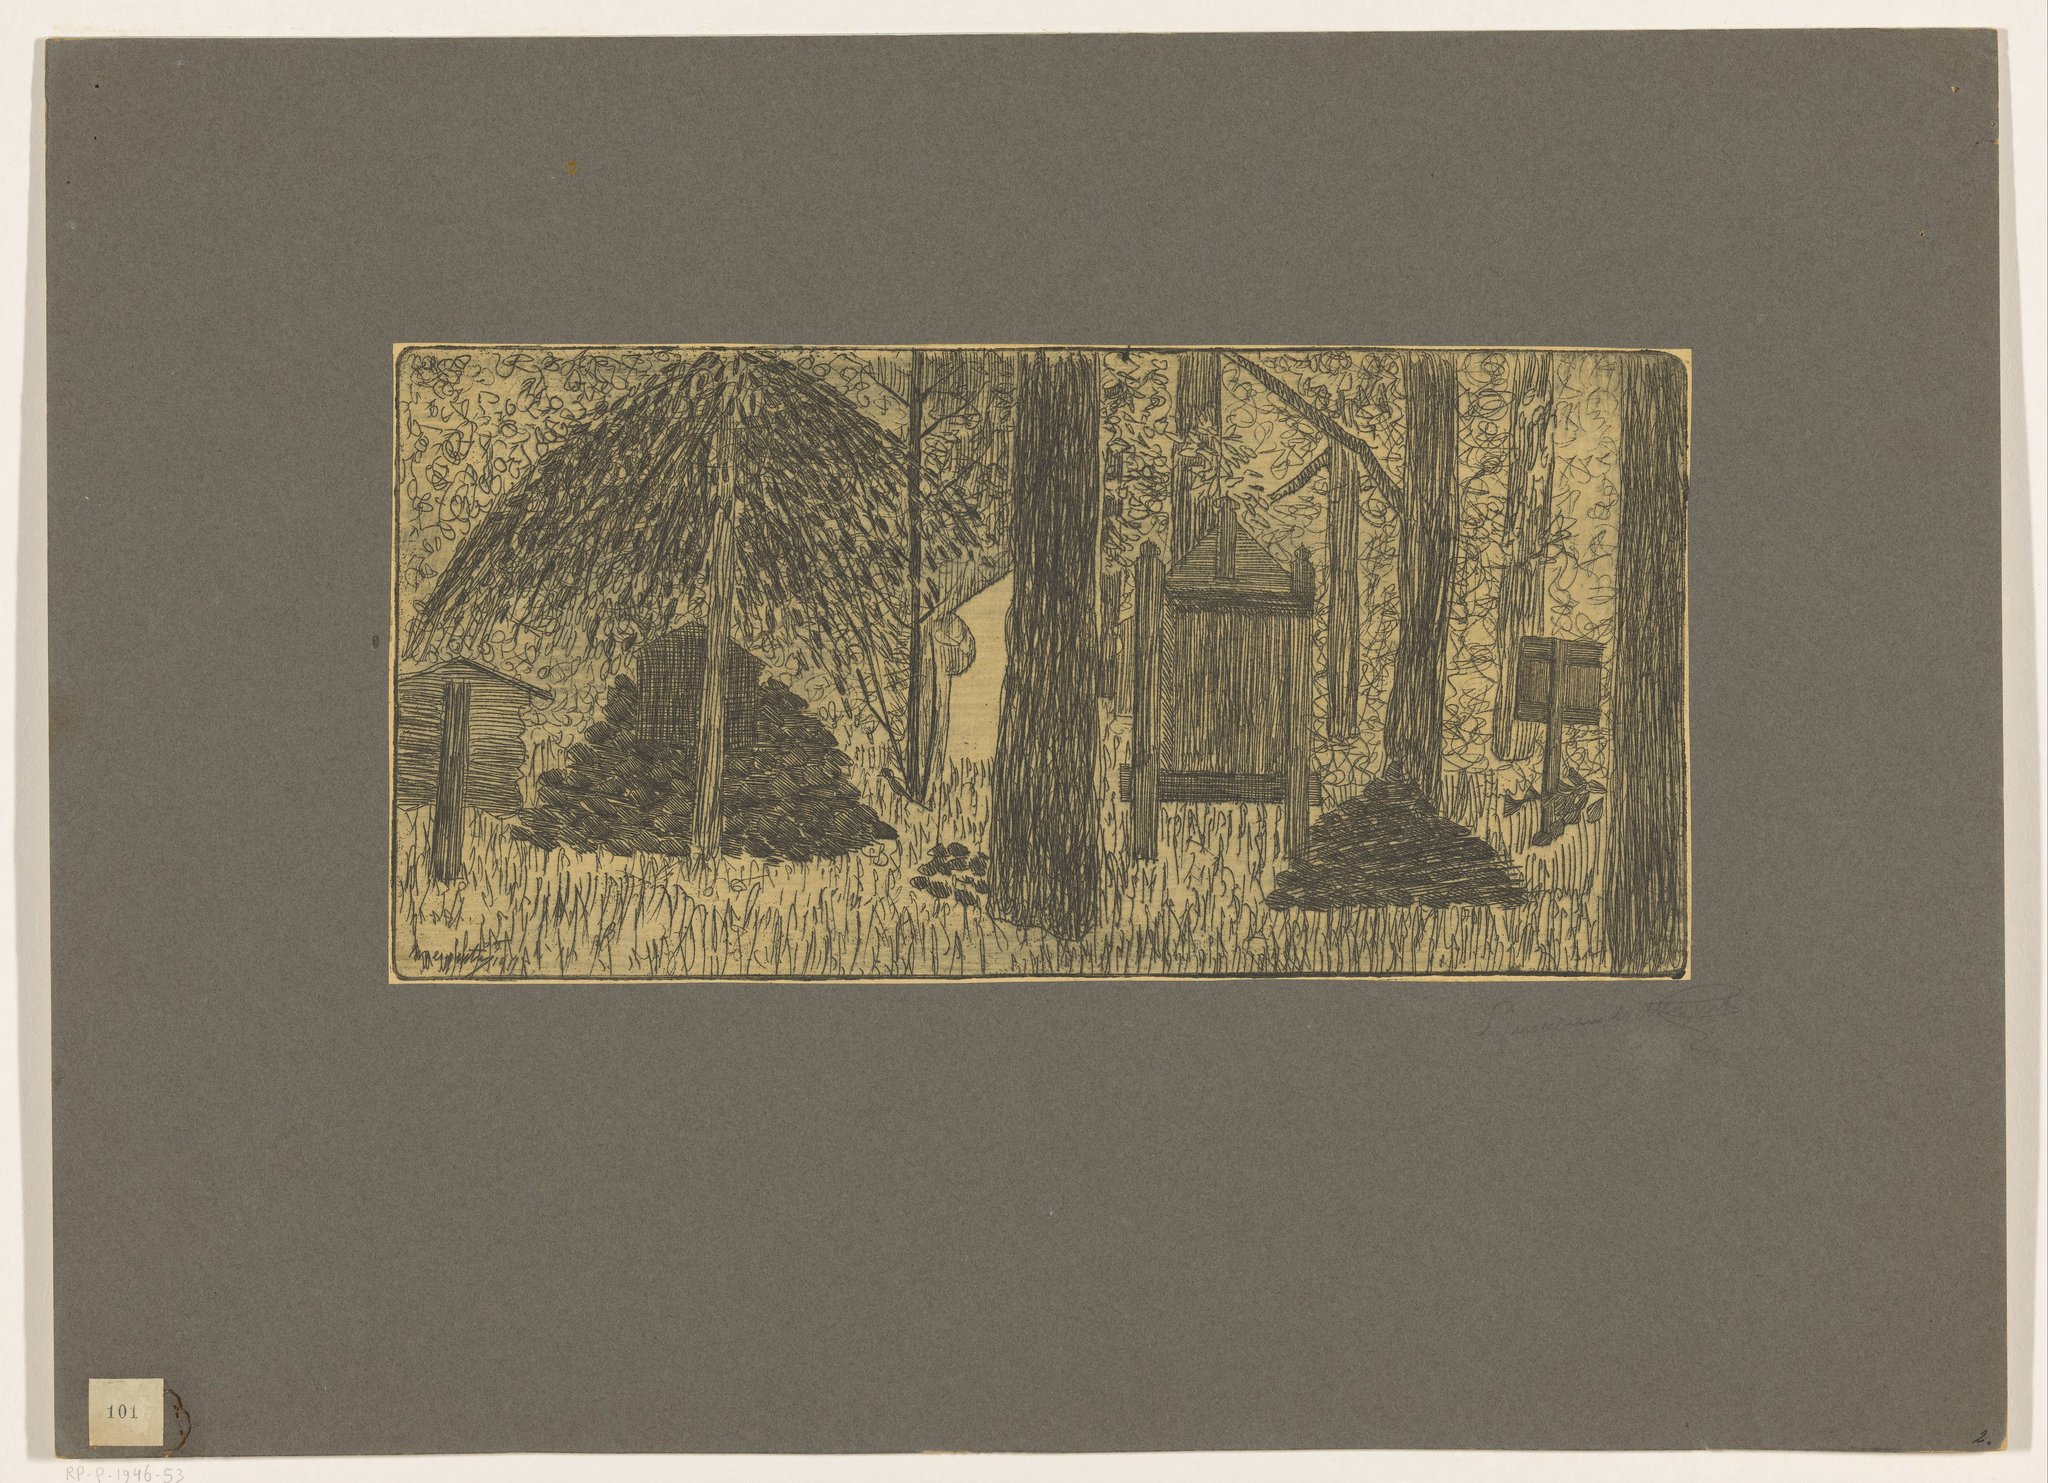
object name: print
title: Bijenkorven tussen bomen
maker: samuel jessurun de mesquita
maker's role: draughtsman, print maker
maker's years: 1868-1944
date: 1911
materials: paper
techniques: etching, intaglio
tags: forest, wood, bee-hive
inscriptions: collector's mark: Lugt 2228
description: Links een vogel in het gras; rechts een bord op een paal.